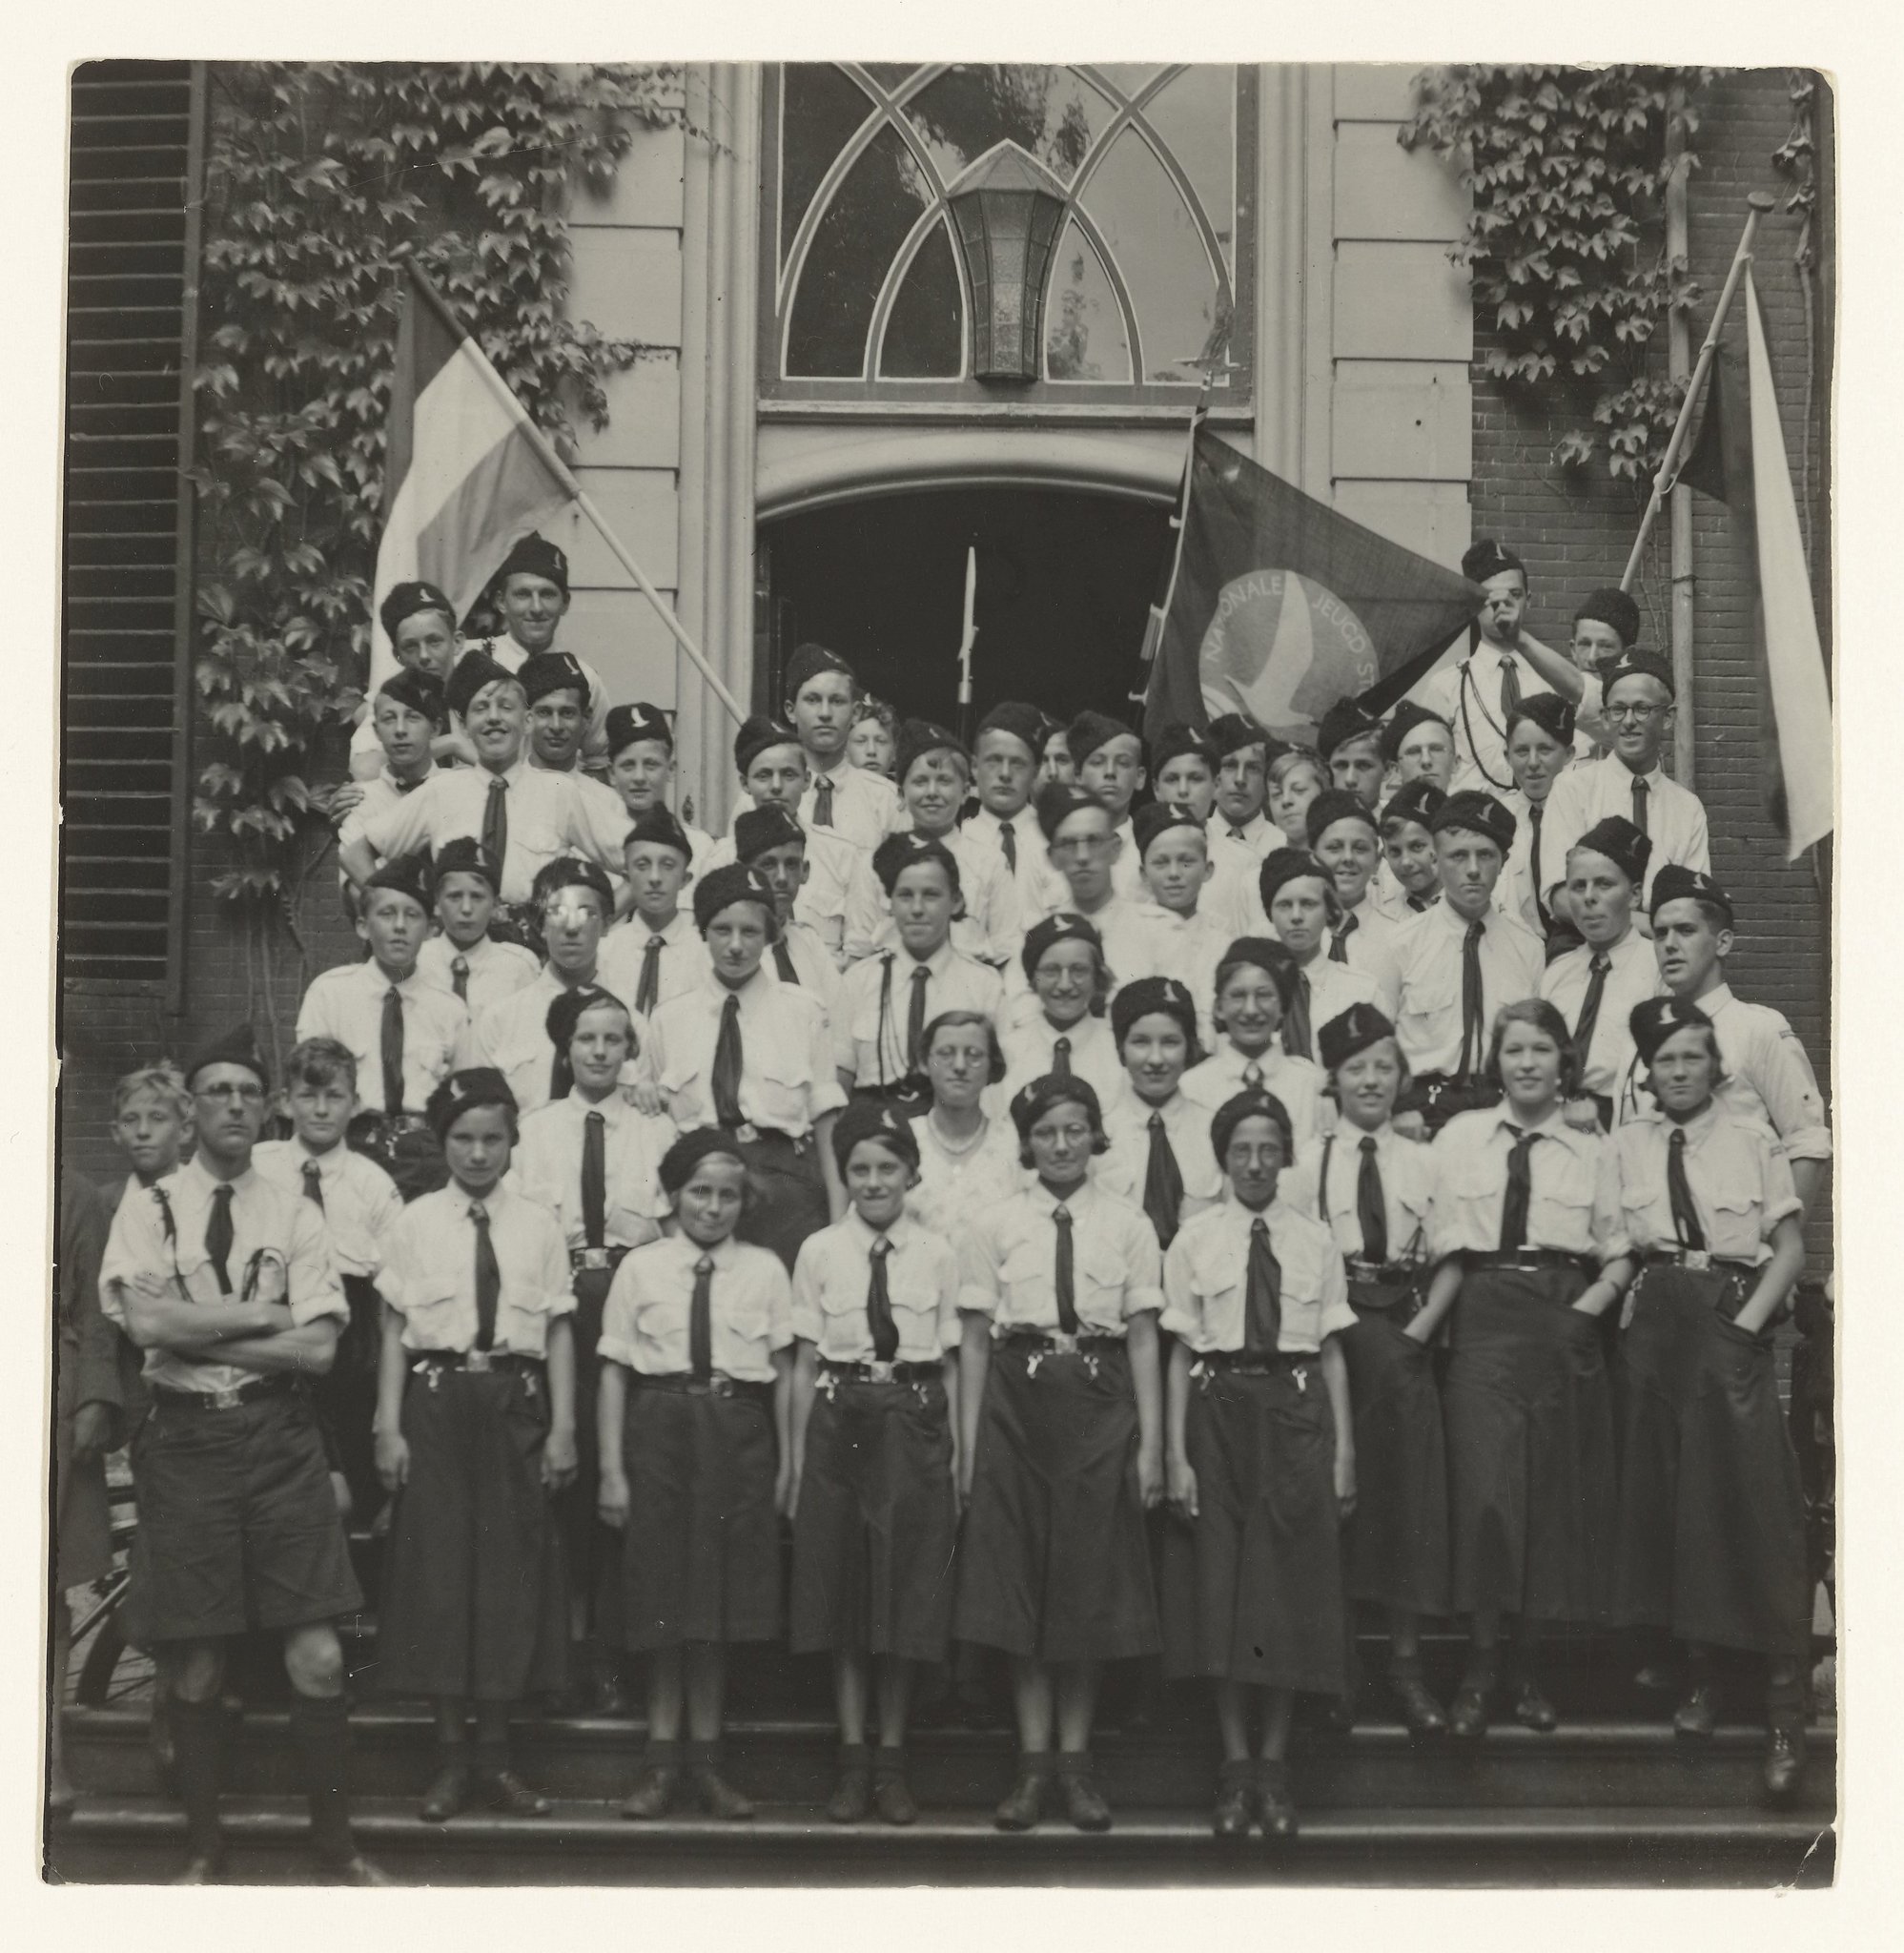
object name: photograph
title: Jeugdstorm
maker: Anonymous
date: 1933-1940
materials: photographic support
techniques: photography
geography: bunnik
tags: nsb, nationale jeugdstorm (njs), bunnik, rhijnauwen, tweede wereldoorlog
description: Een groep jongens en meisjes, met volwassen begeleiders, in het uniform van de (Nationale) Jeugdstorm op het bordes van een voormalig kasteel, landgoed Rhijnauwen, sinds 1933 een jeugdherberg. Op de achtergrond de Nederlandse vlag en de vlag van de Jeugdstorm: een vliegende meeuw met daarom heen de tekst "Nationale Jeugdstorm".